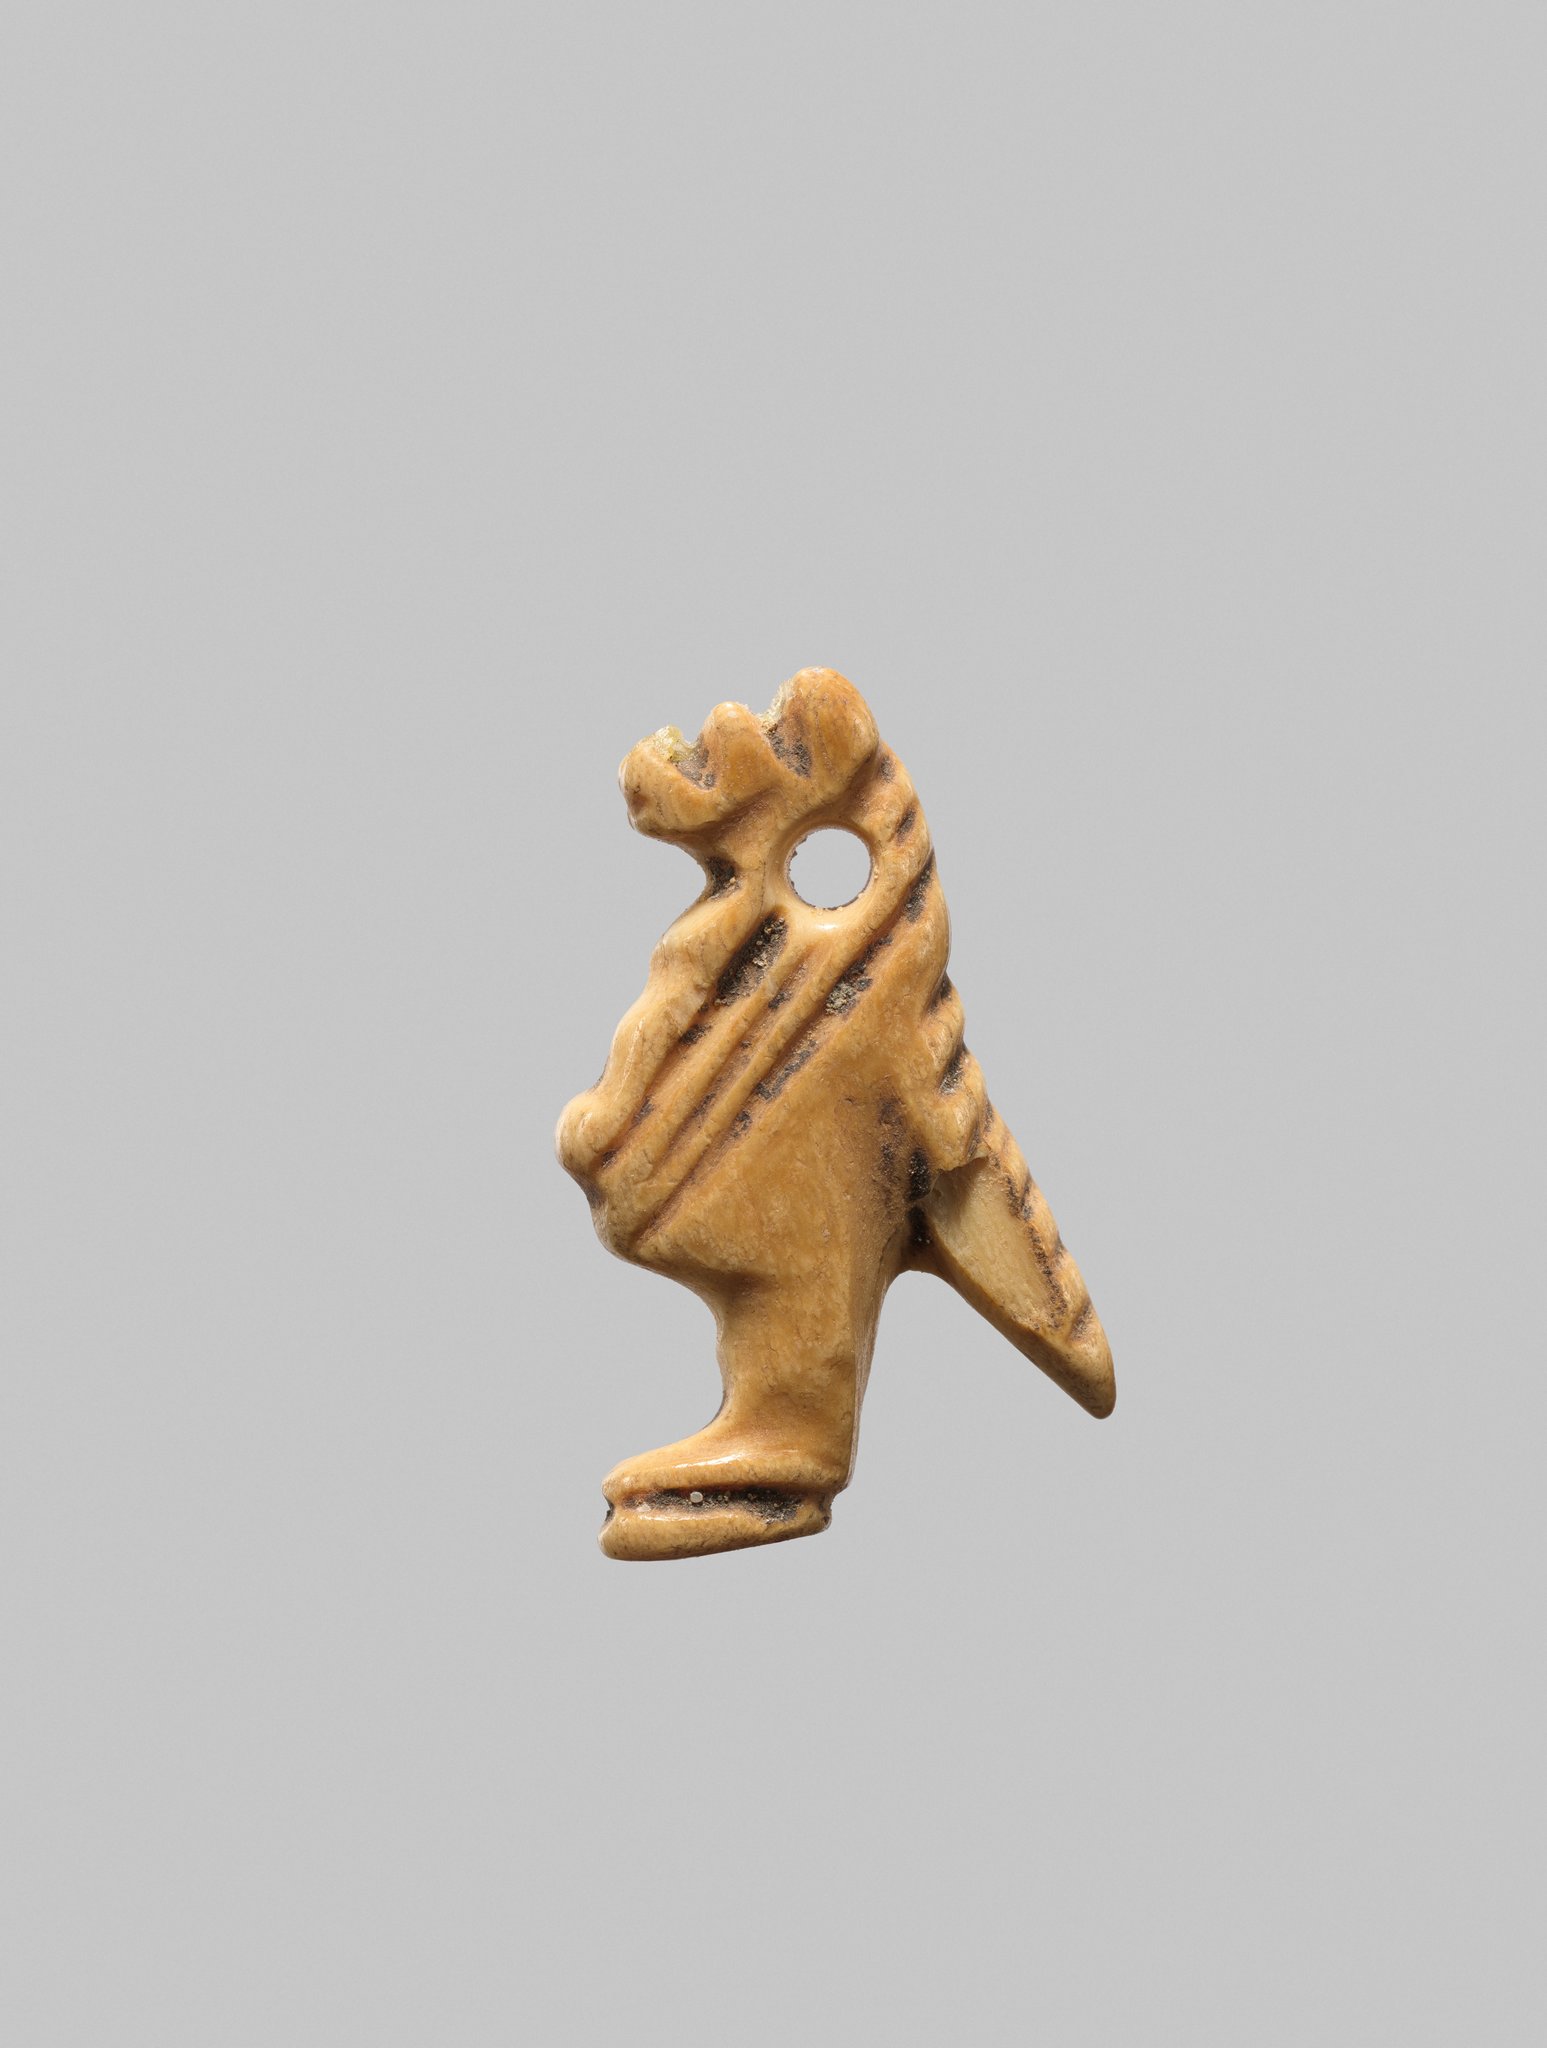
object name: amulet, taweret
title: Taweret amulet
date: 2150-1950 BCE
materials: bone, ivory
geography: egypt